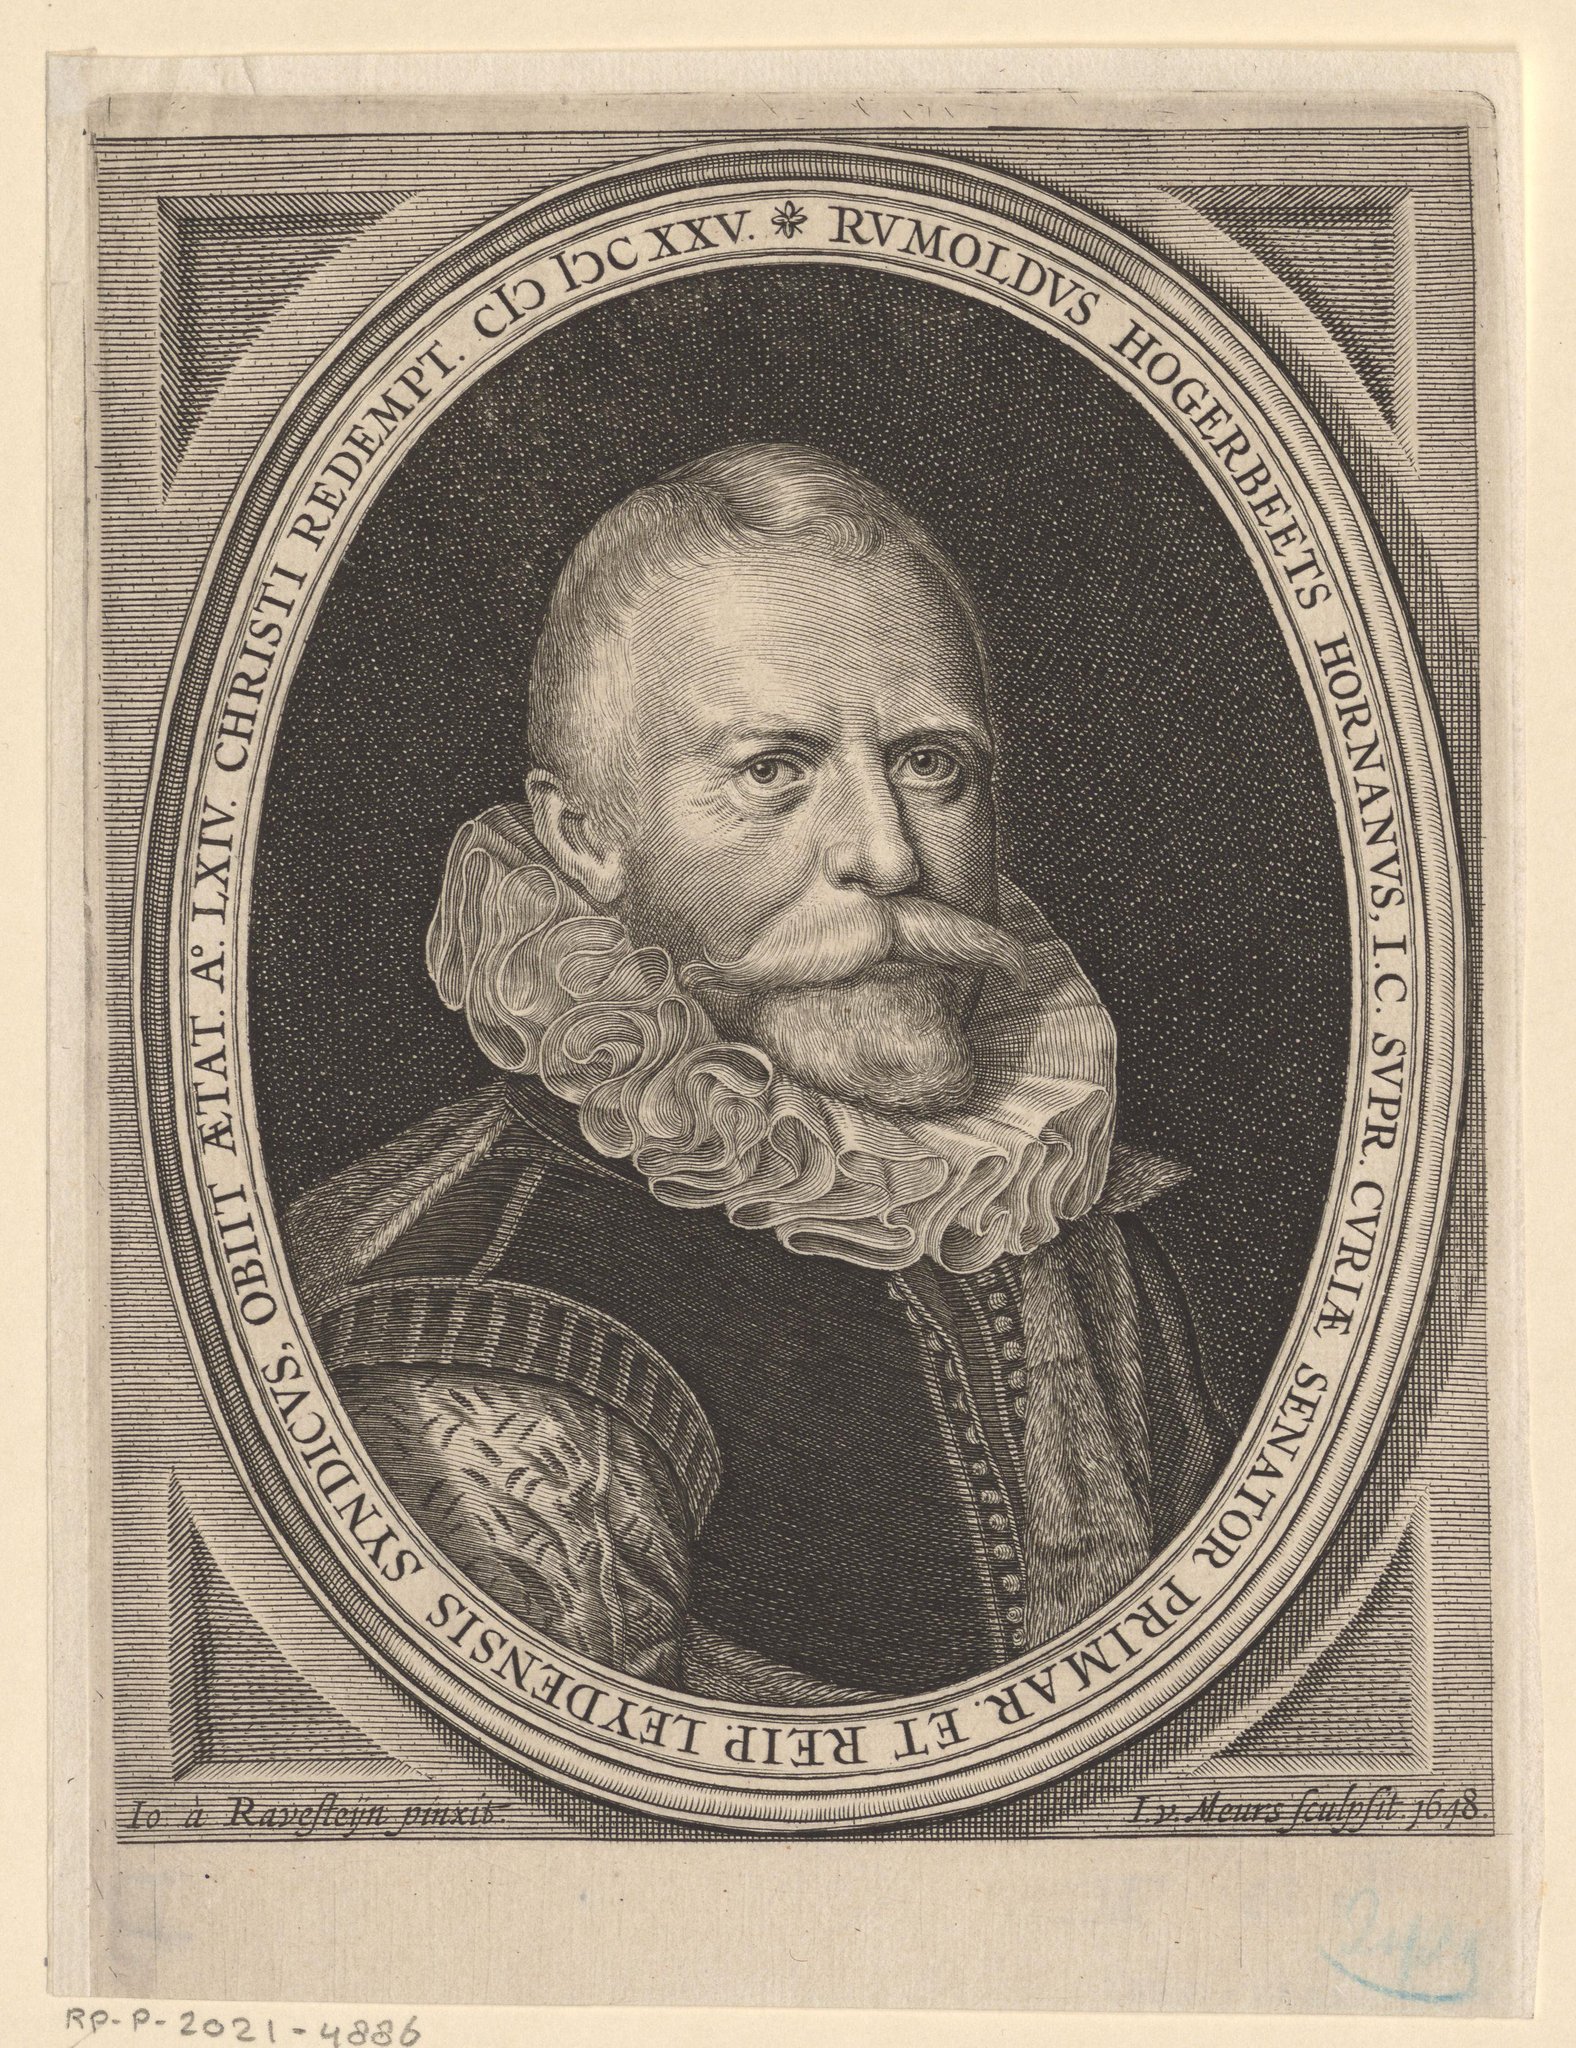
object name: print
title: Portret van Rombout Hogerbeets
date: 1648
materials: paper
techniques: engraving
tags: hoorn (north holland), historical persons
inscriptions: date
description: Prent ook gebruikt in: Velius, Theodorus. Chroniick van Hoorn. Hoorn: Isaac Willemsz van der Beeck, 1648.